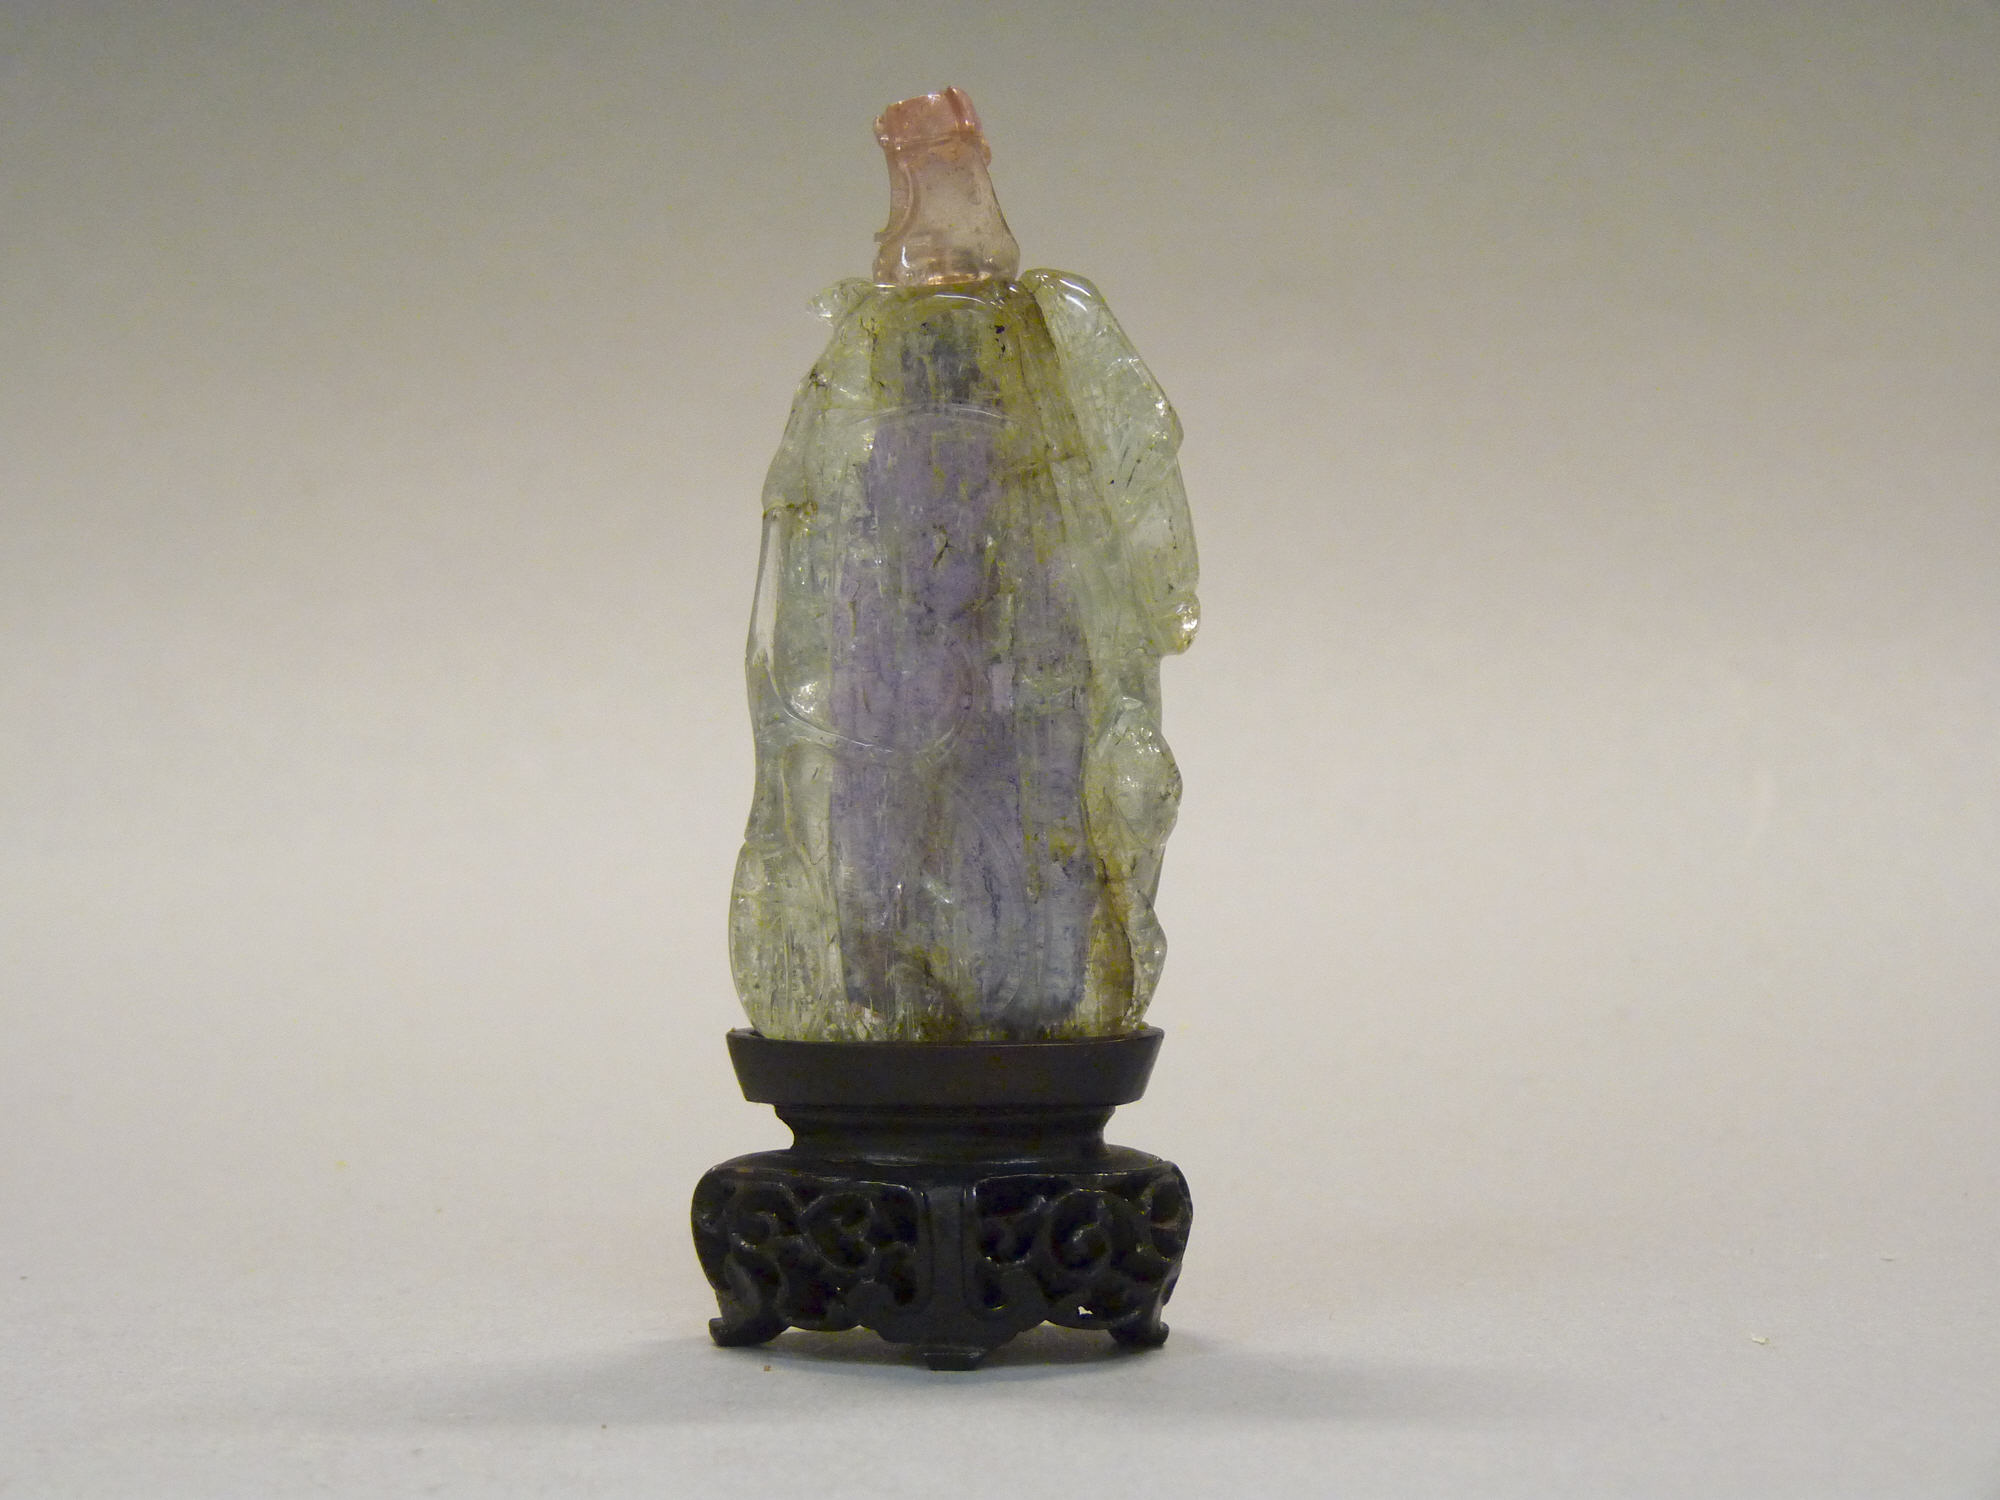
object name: snuff bottle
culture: chinese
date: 1851-1900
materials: gemstone, wood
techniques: stain